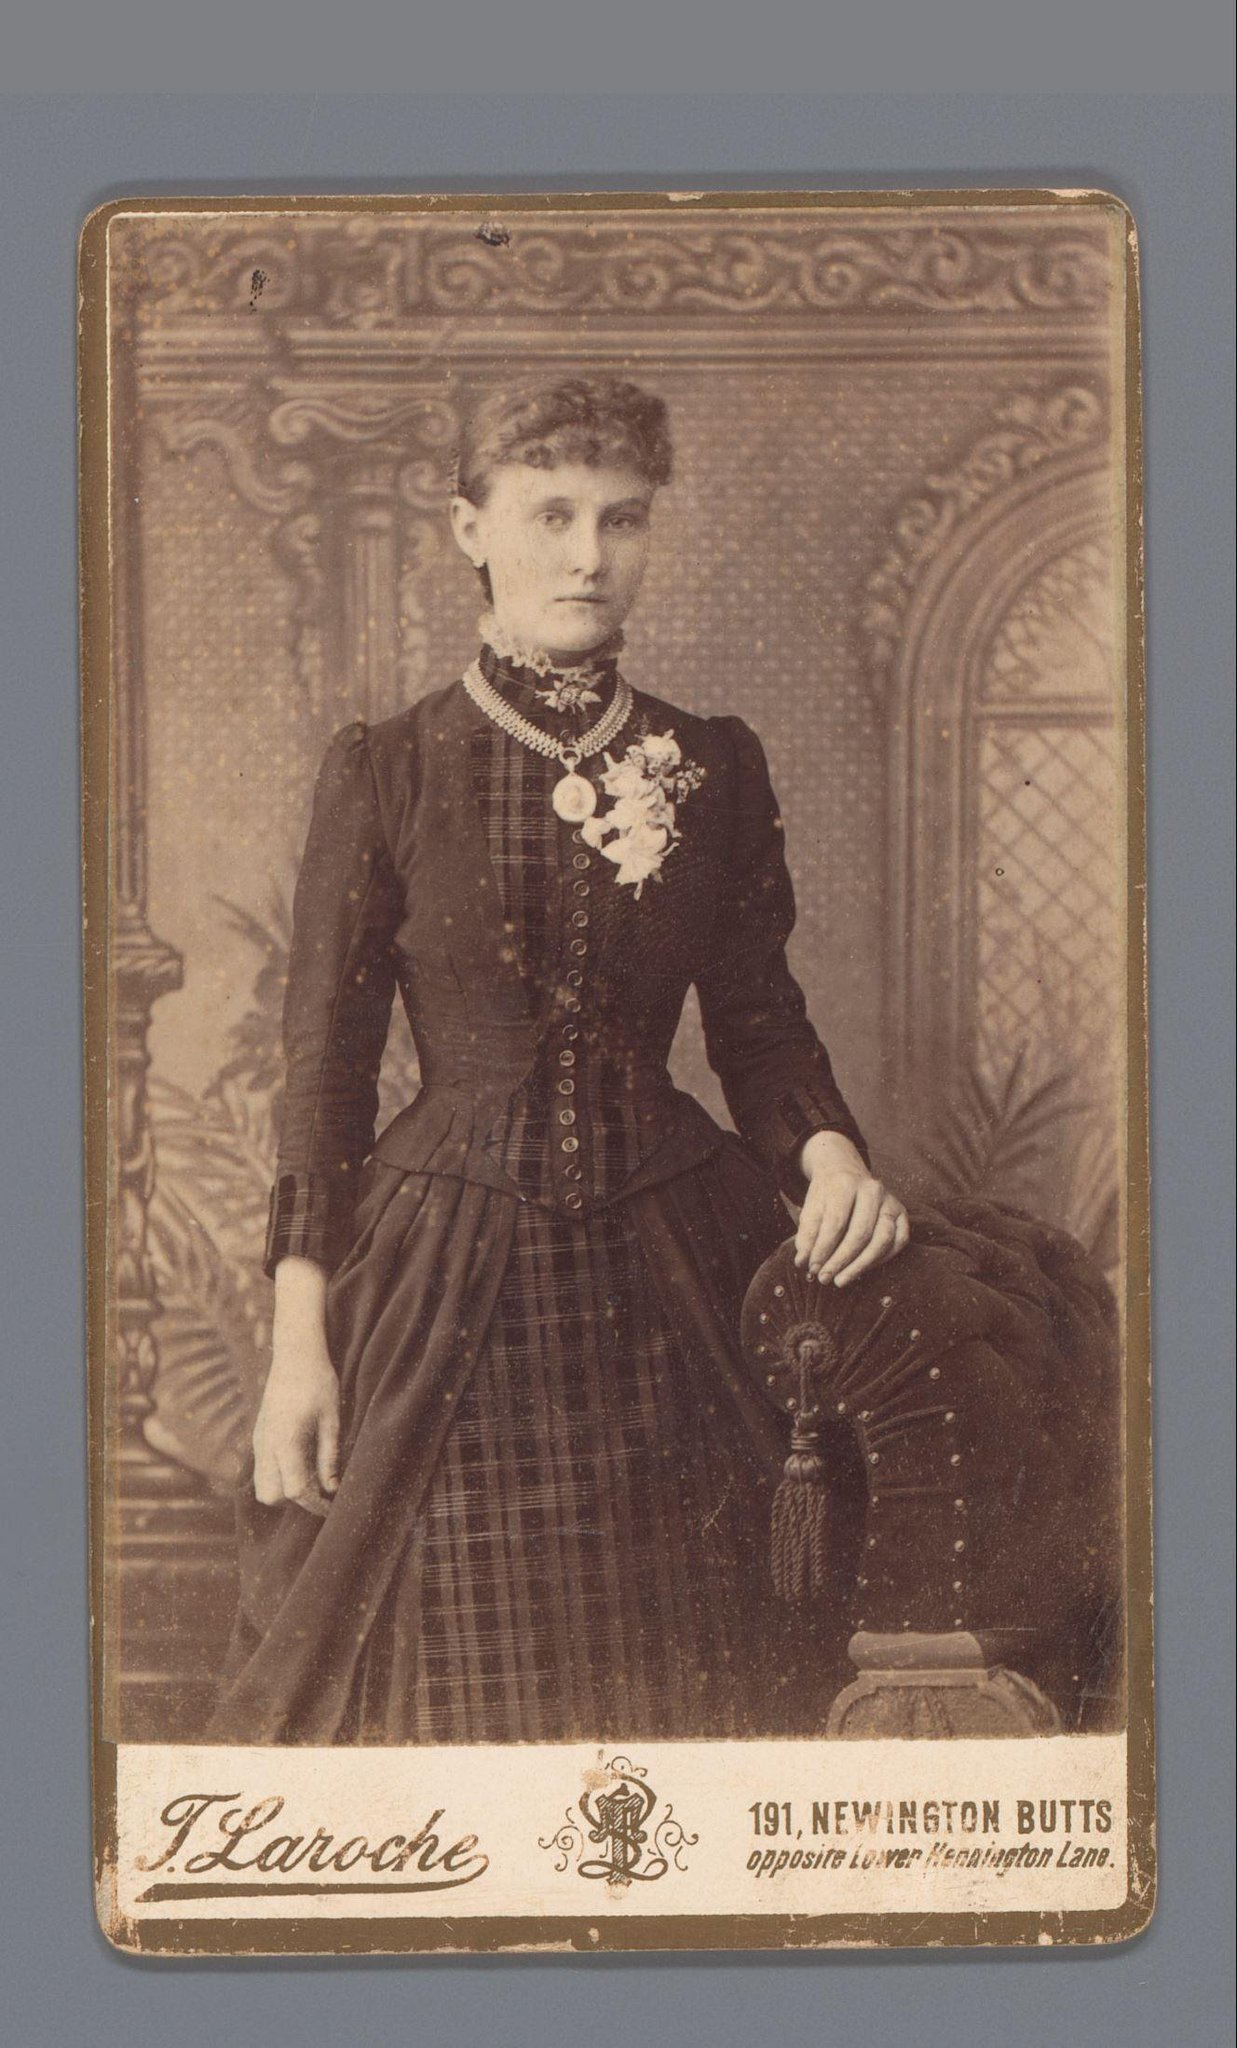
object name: carte de visite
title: Portret van een onbekende staande vrouw naast een fauteuil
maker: t. laroche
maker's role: fotograaf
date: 1880-1900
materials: cardboard, paper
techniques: albumen print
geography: london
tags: historical persons - bb - woman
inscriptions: inscription: ‘TL/ THE Don Photographic/ STUDIO/ T. Laroche/ 191/ NEWINGTON BUTTS./ opposite Lower Kennington Lane./ S.E./ [...]’